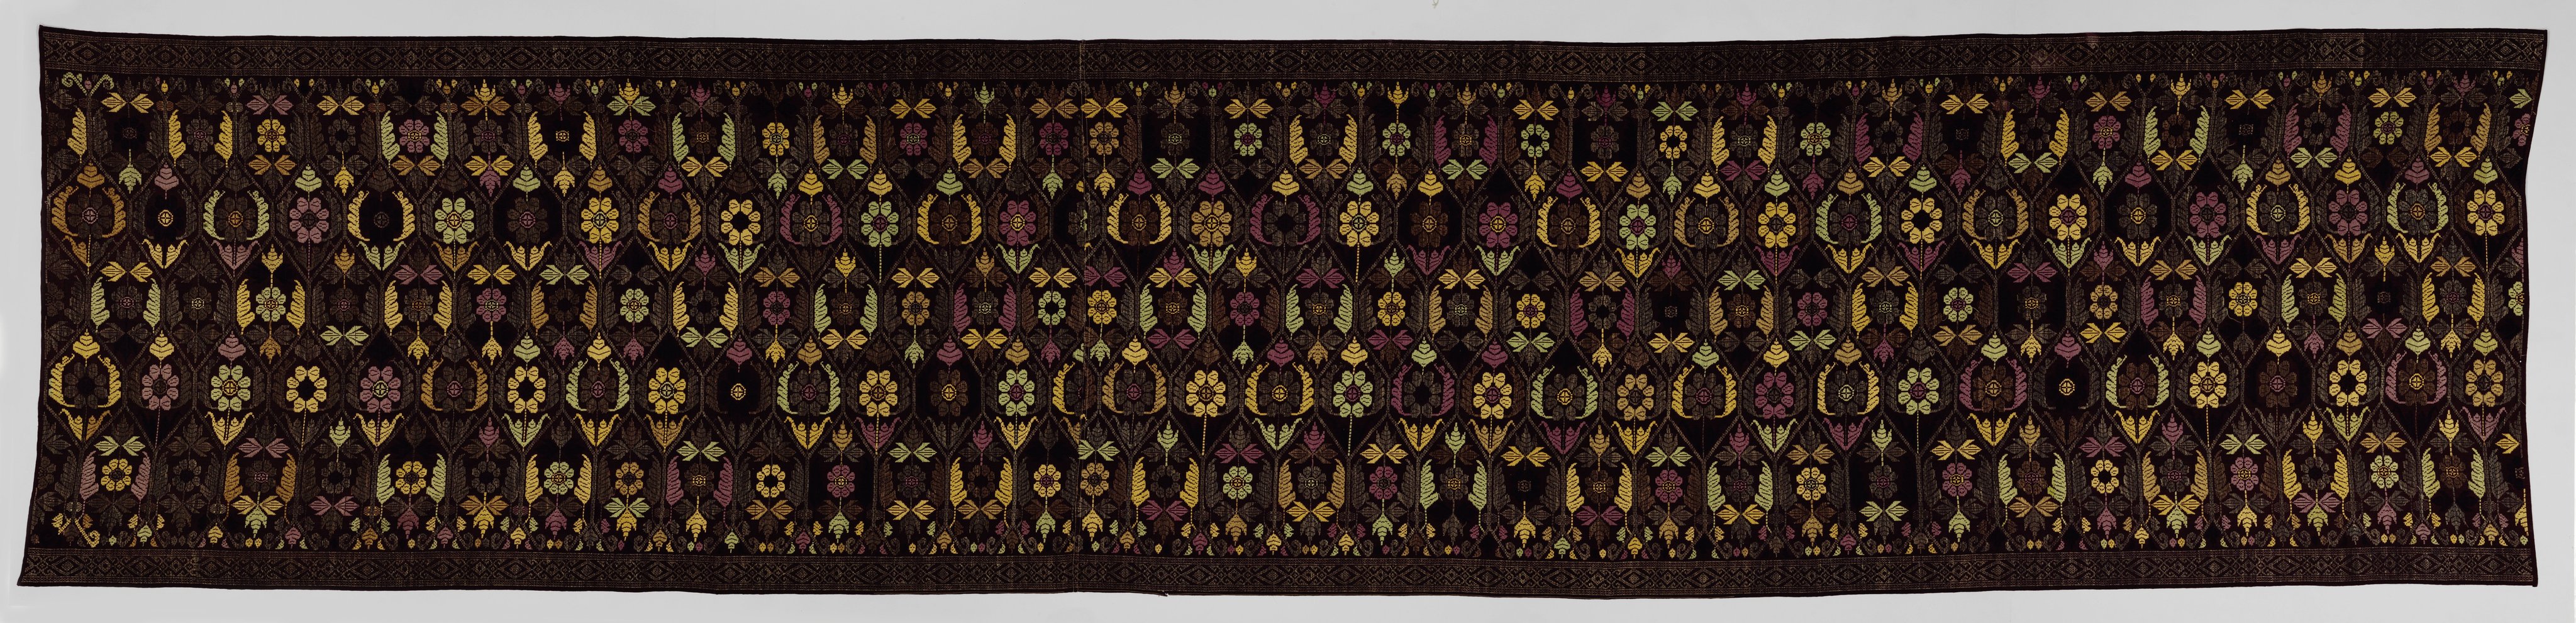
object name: cloth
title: Tempeldoek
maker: Anonymous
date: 1900-1949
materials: gold thread, silk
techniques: brocade, weave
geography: bali